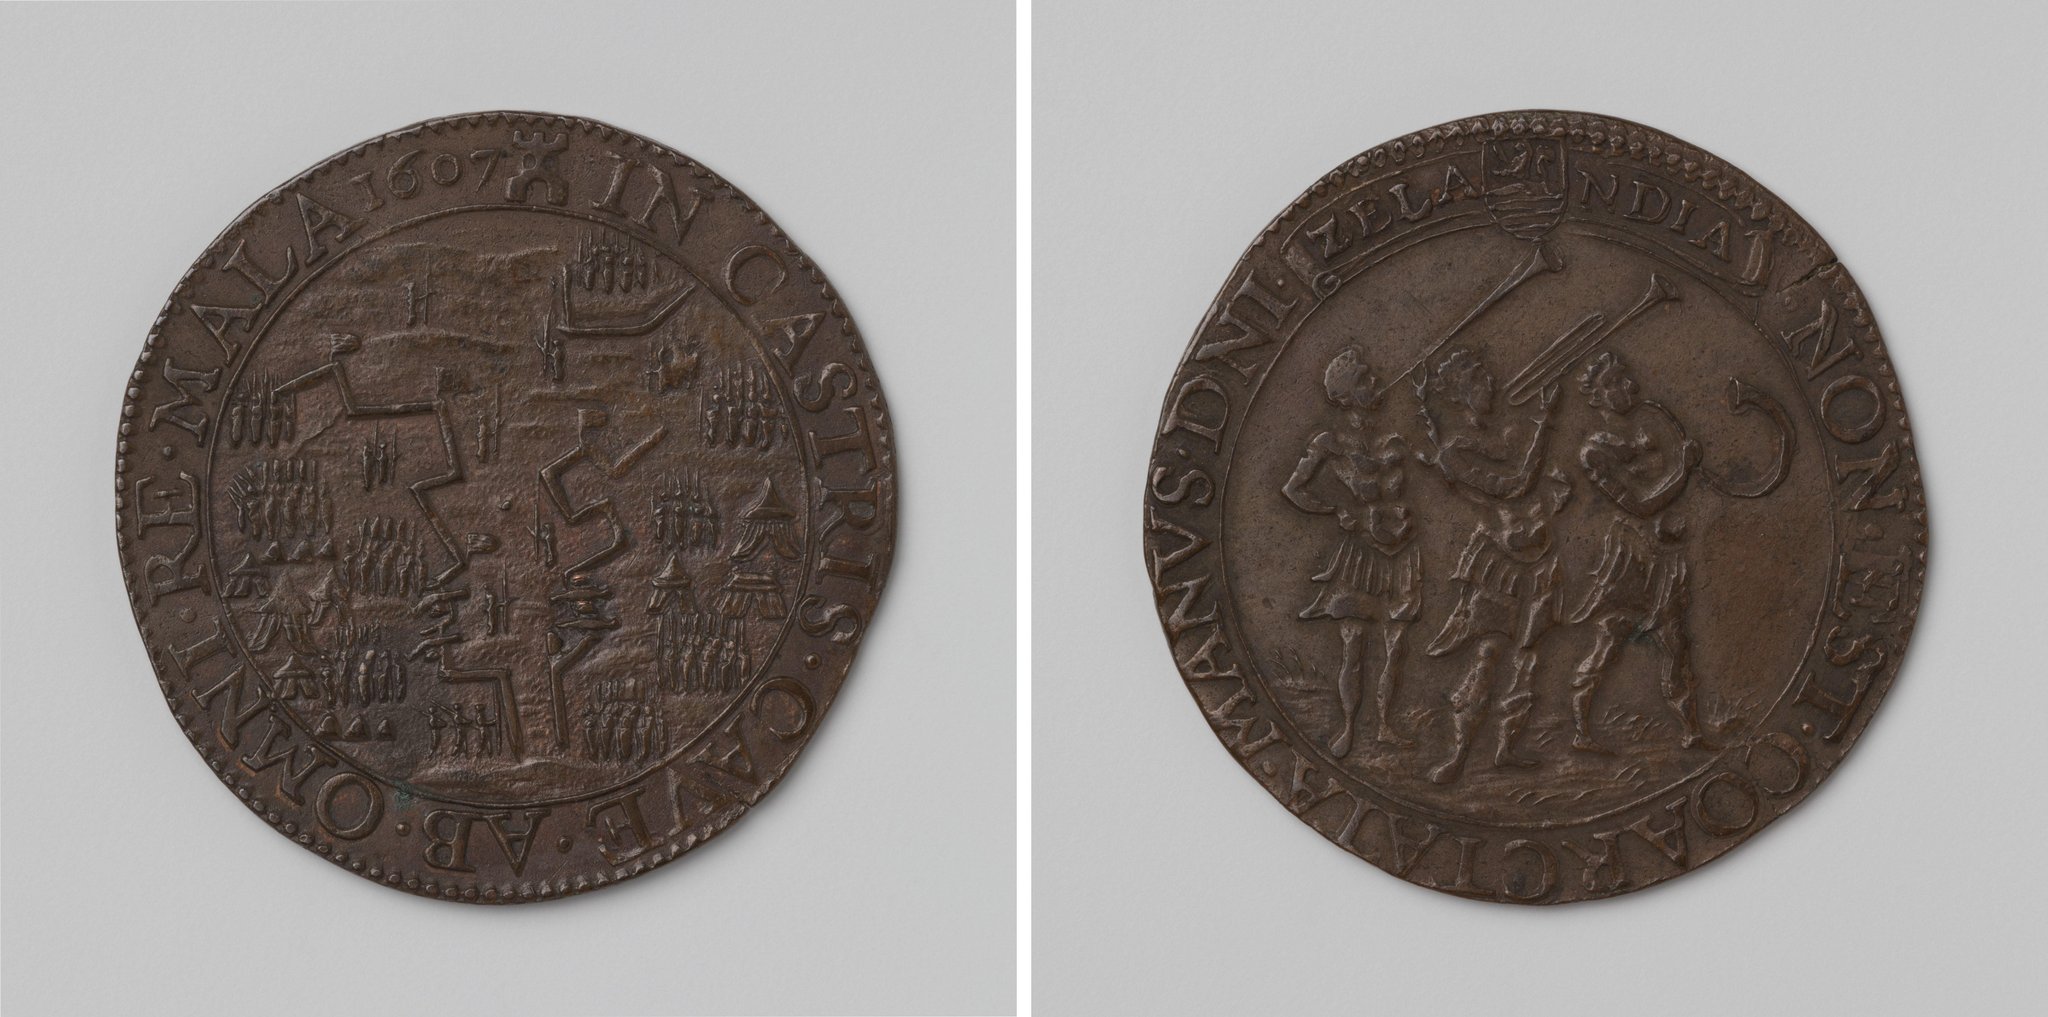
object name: jeton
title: Wapenstilstand te land voor de duur van acht maanden gesloten tussen de Republiek en Spanje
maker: Anonymous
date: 1607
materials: copper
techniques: striking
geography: middelburg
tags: zeeland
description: Koperen penning. Voorzijde: twee tegenover elkaar liggende legers binnen omschrift. Keerzijde: drie mannen blazend op bazuinen onder wimpel met opschrift, onderbroken door wapenschild binnen omschrift